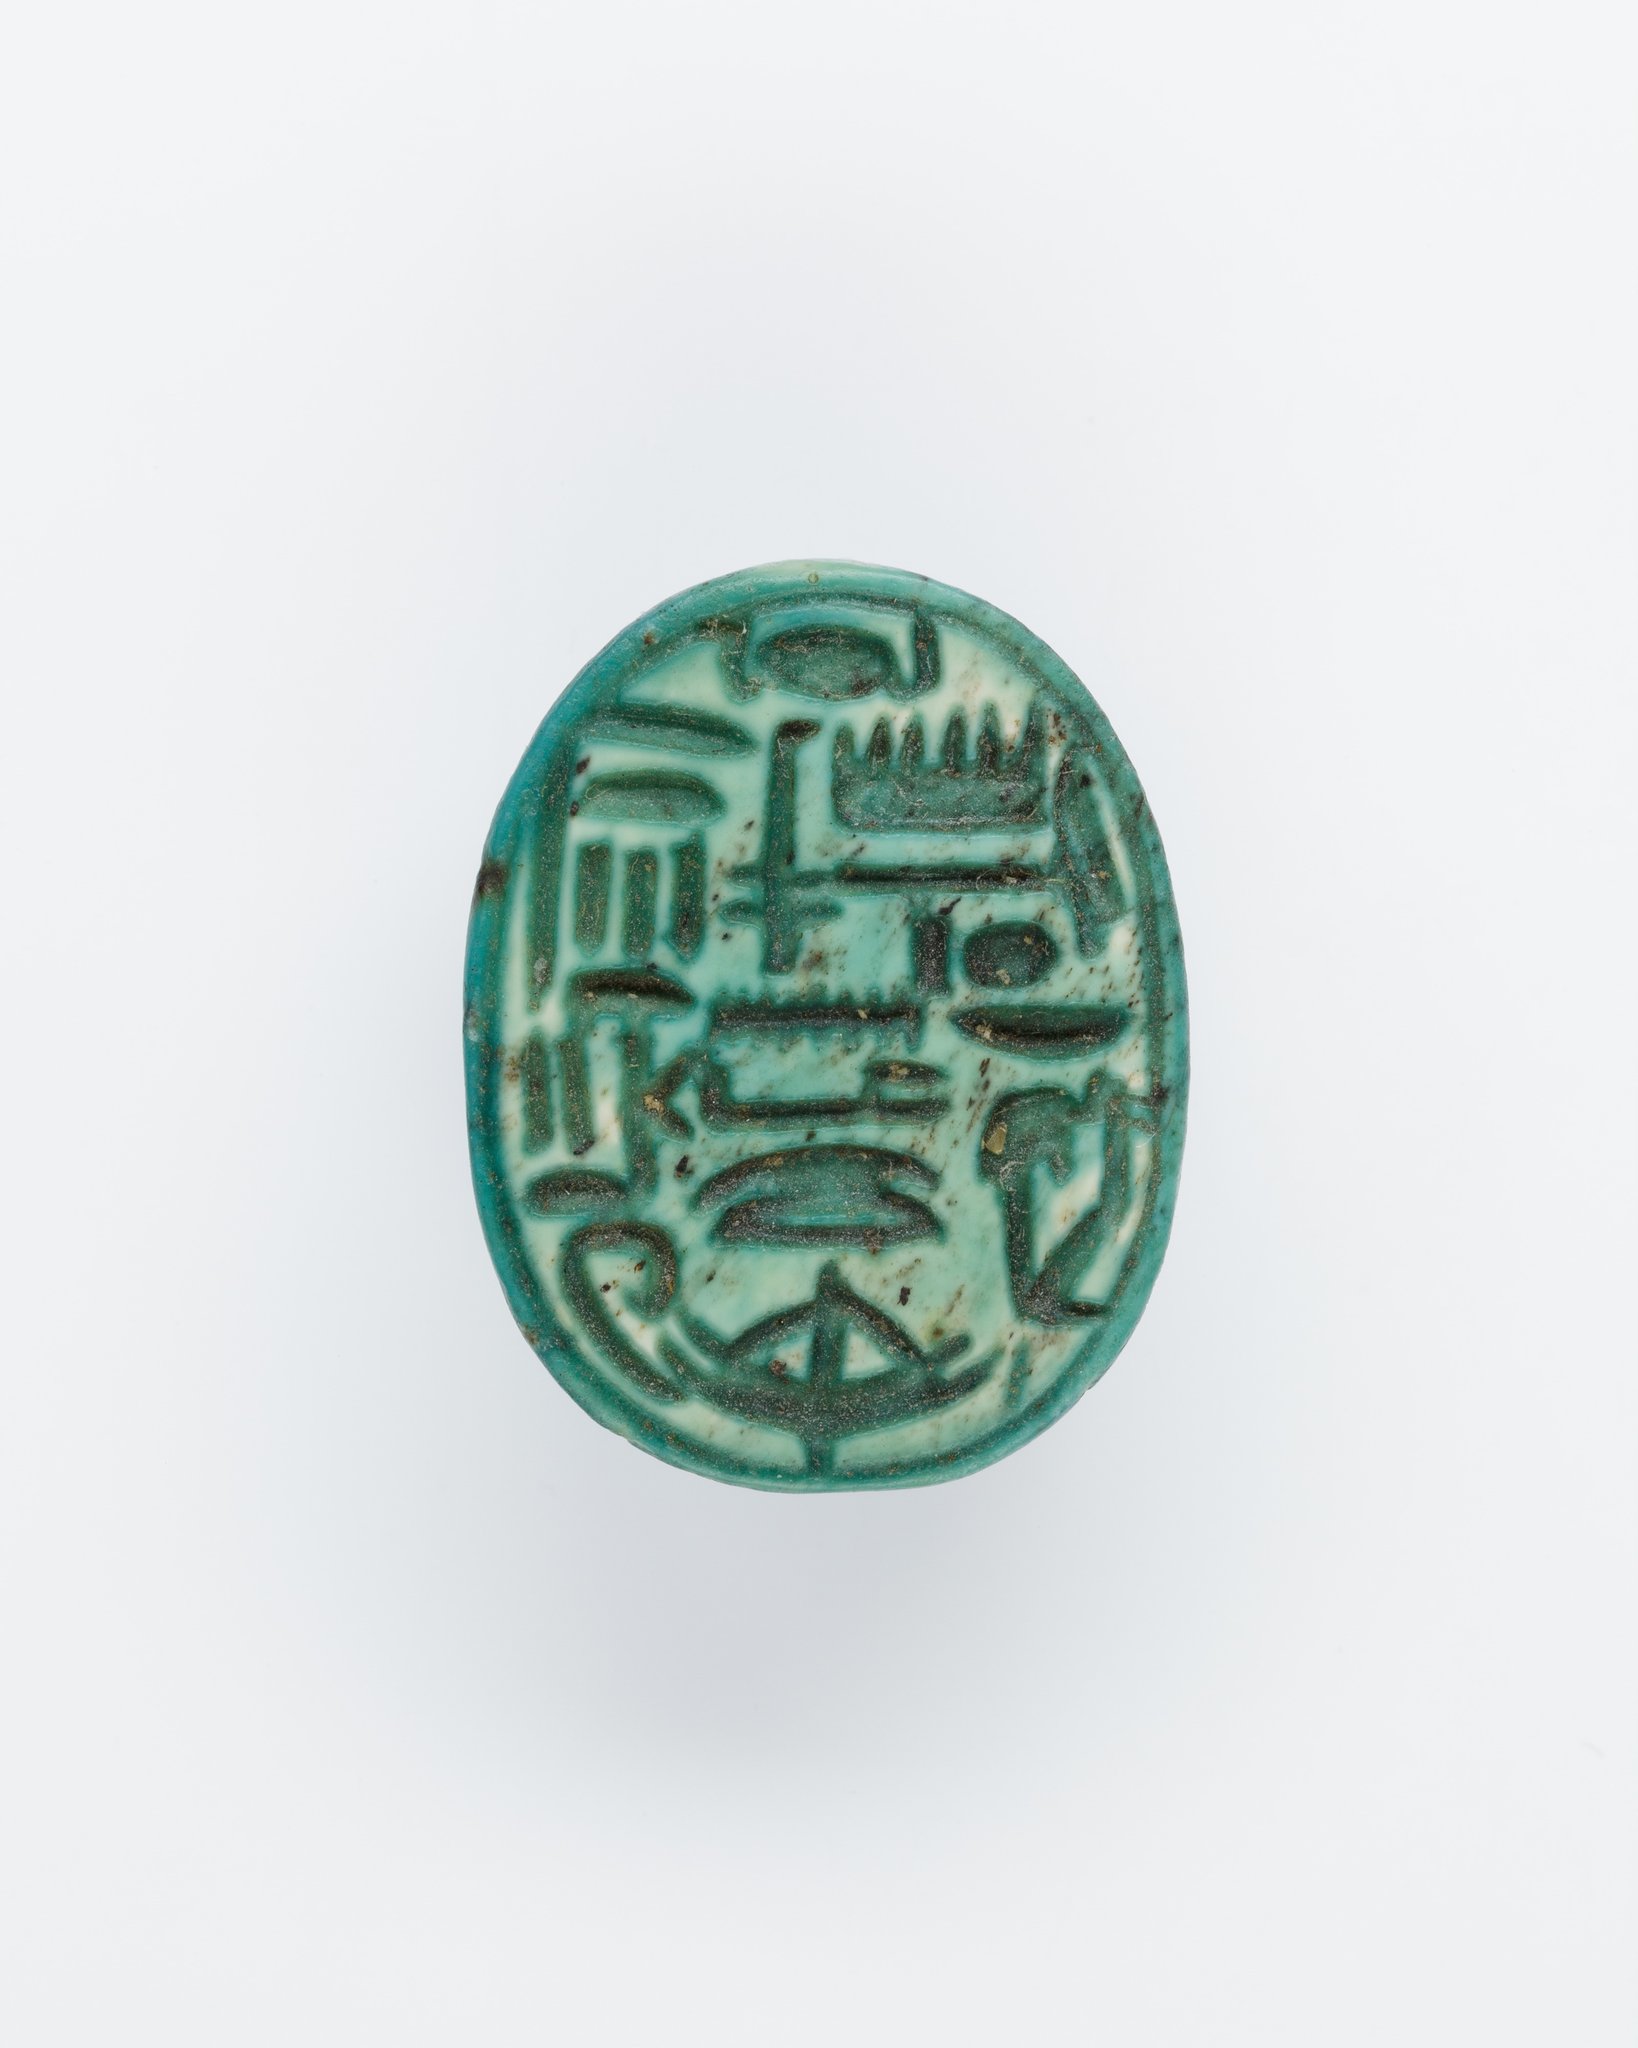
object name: scarab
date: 1295-1070 BCE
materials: stone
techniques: glazing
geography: egypt